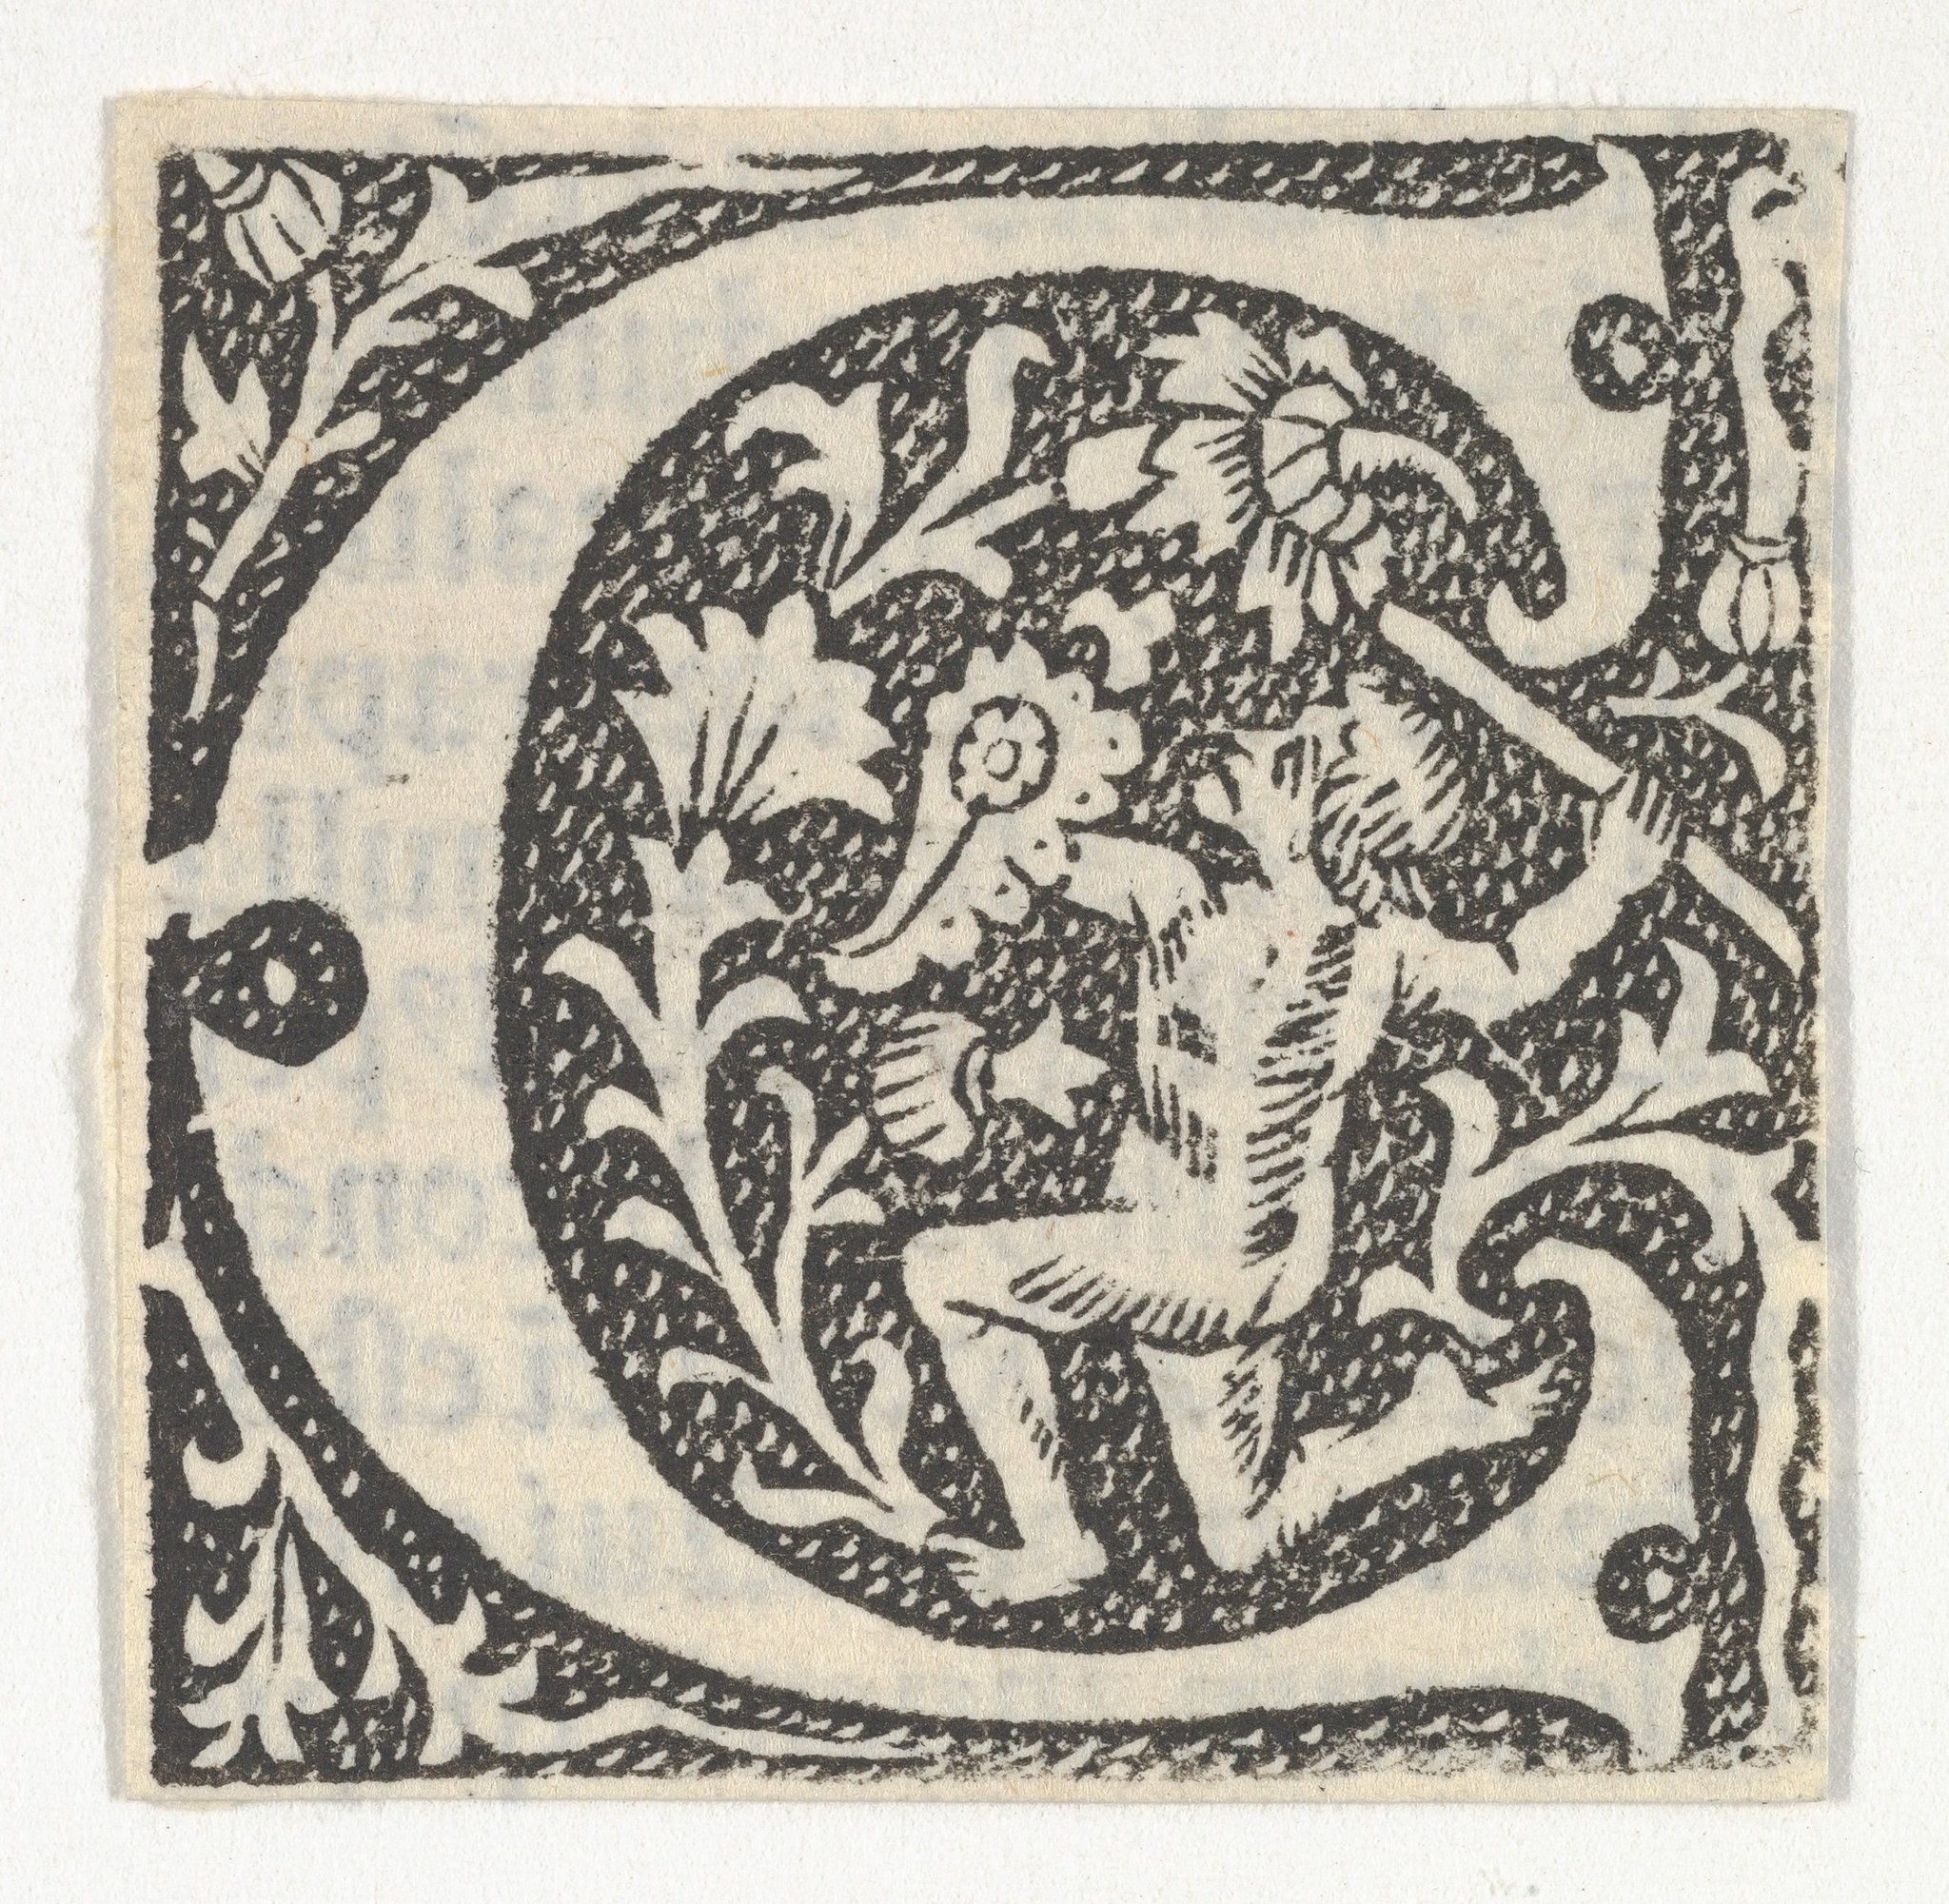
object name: print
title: Decorated Roman alphabet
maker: anonymous, french, 15th century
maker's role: artist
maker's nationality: french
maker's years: 1400-1500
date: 1499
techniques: woodcut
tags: men